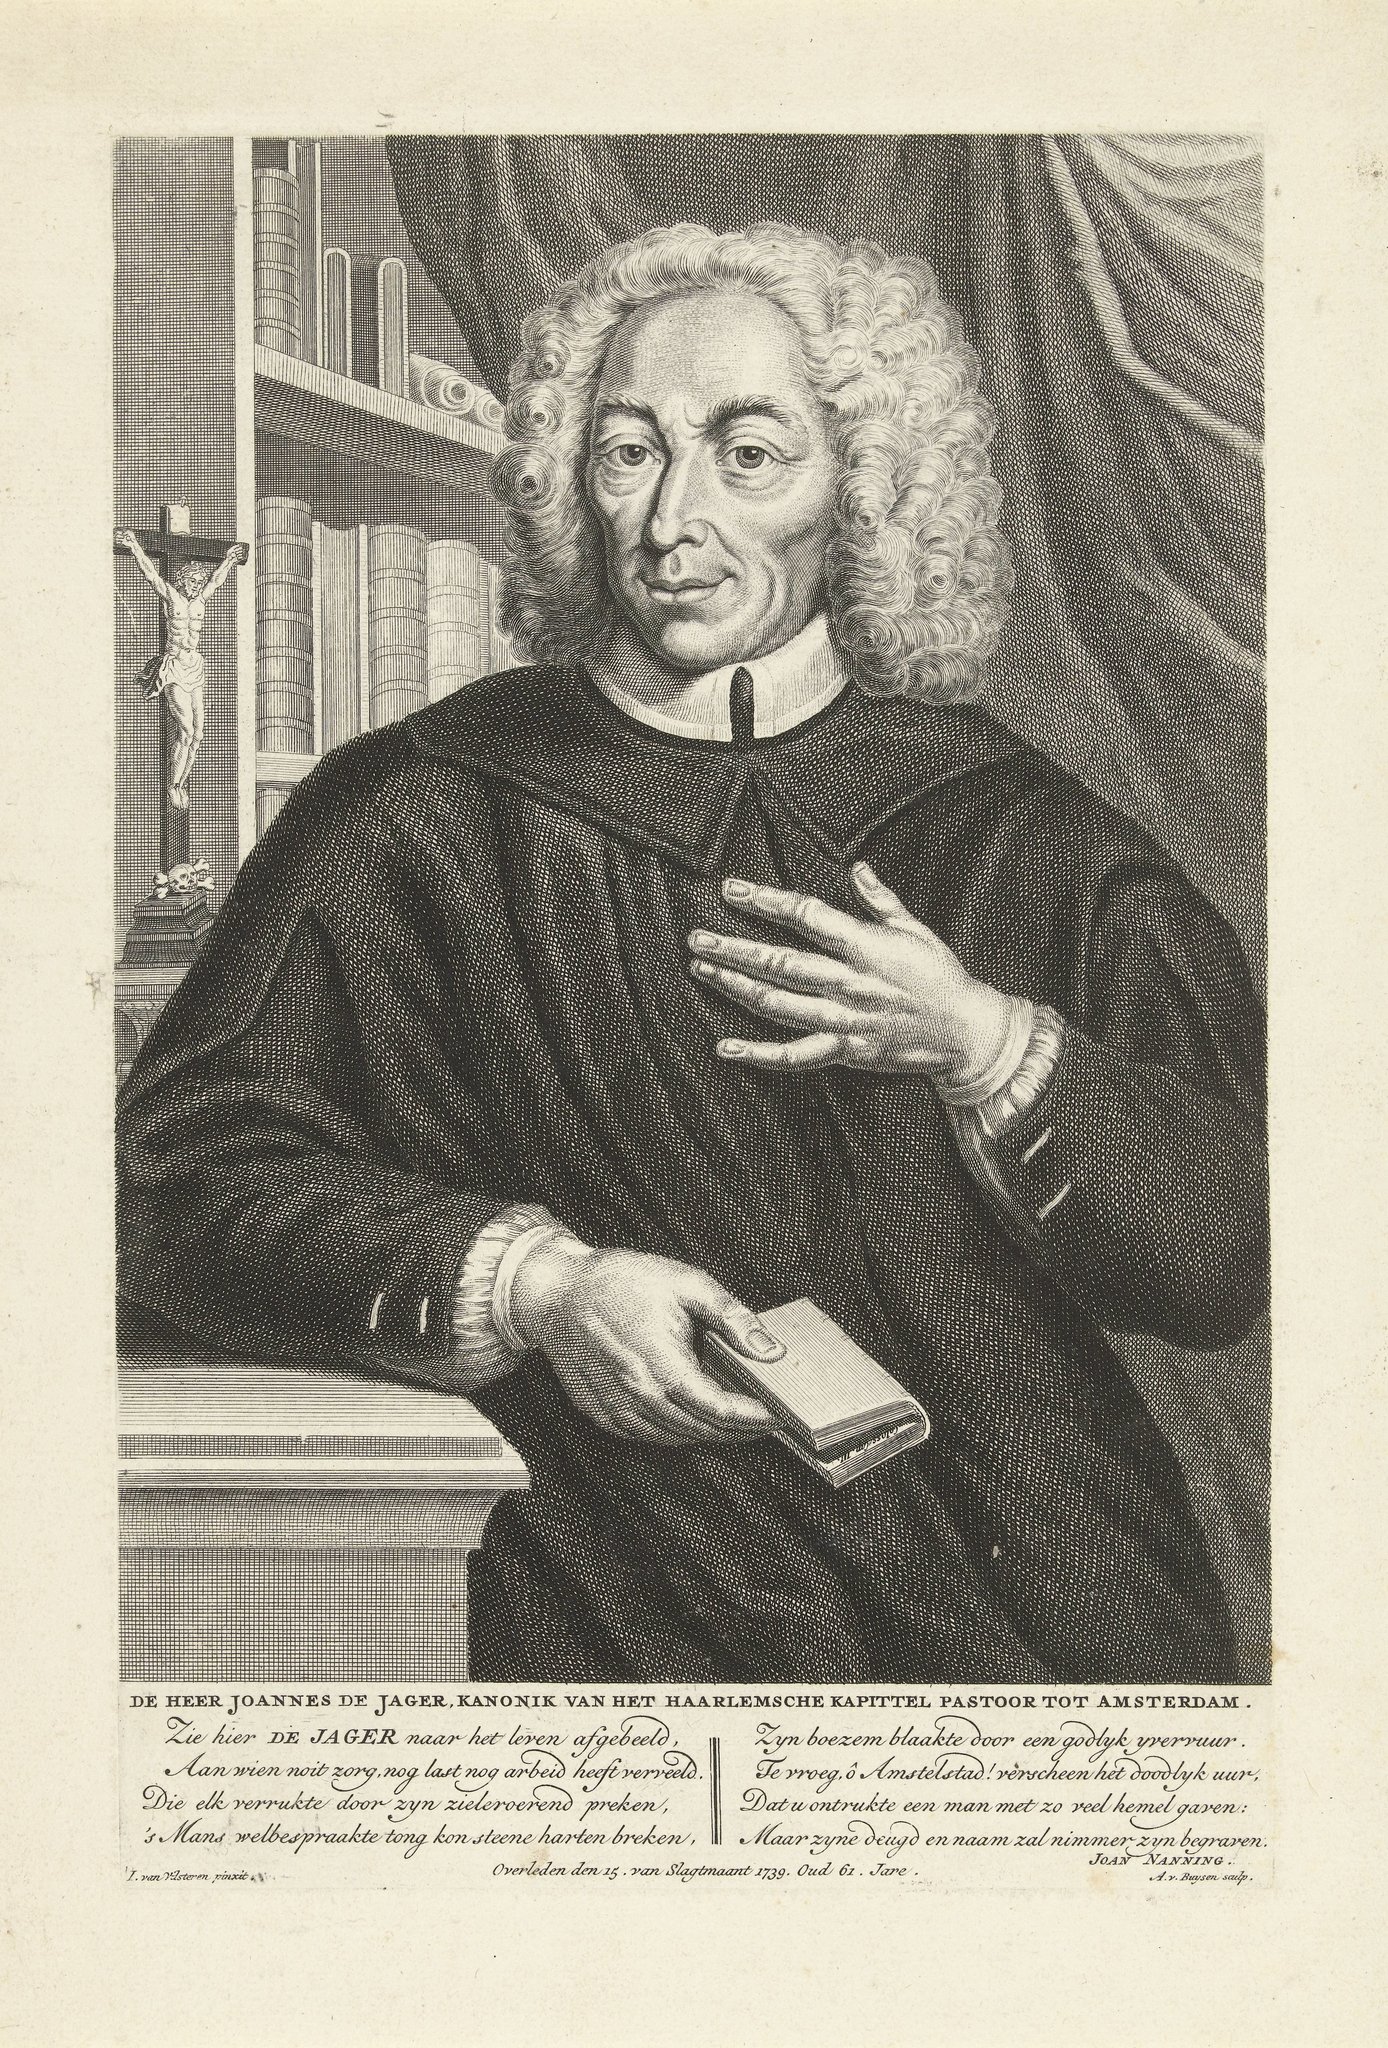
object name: print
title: Portret van Joannes de Jager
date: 1739-1741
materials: paper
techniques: engraving, etching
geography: amsterdam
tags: organization, functionaries and dignitaries in roman catholic church; clergy in general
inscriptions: collector's mark: Lugt 2228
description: Portret van de rooms-katholieke geestelijke Joannes de Jager, met een bijbel in de hand. Onder het portret een lofdicht op de Jager door Joan Nanning.